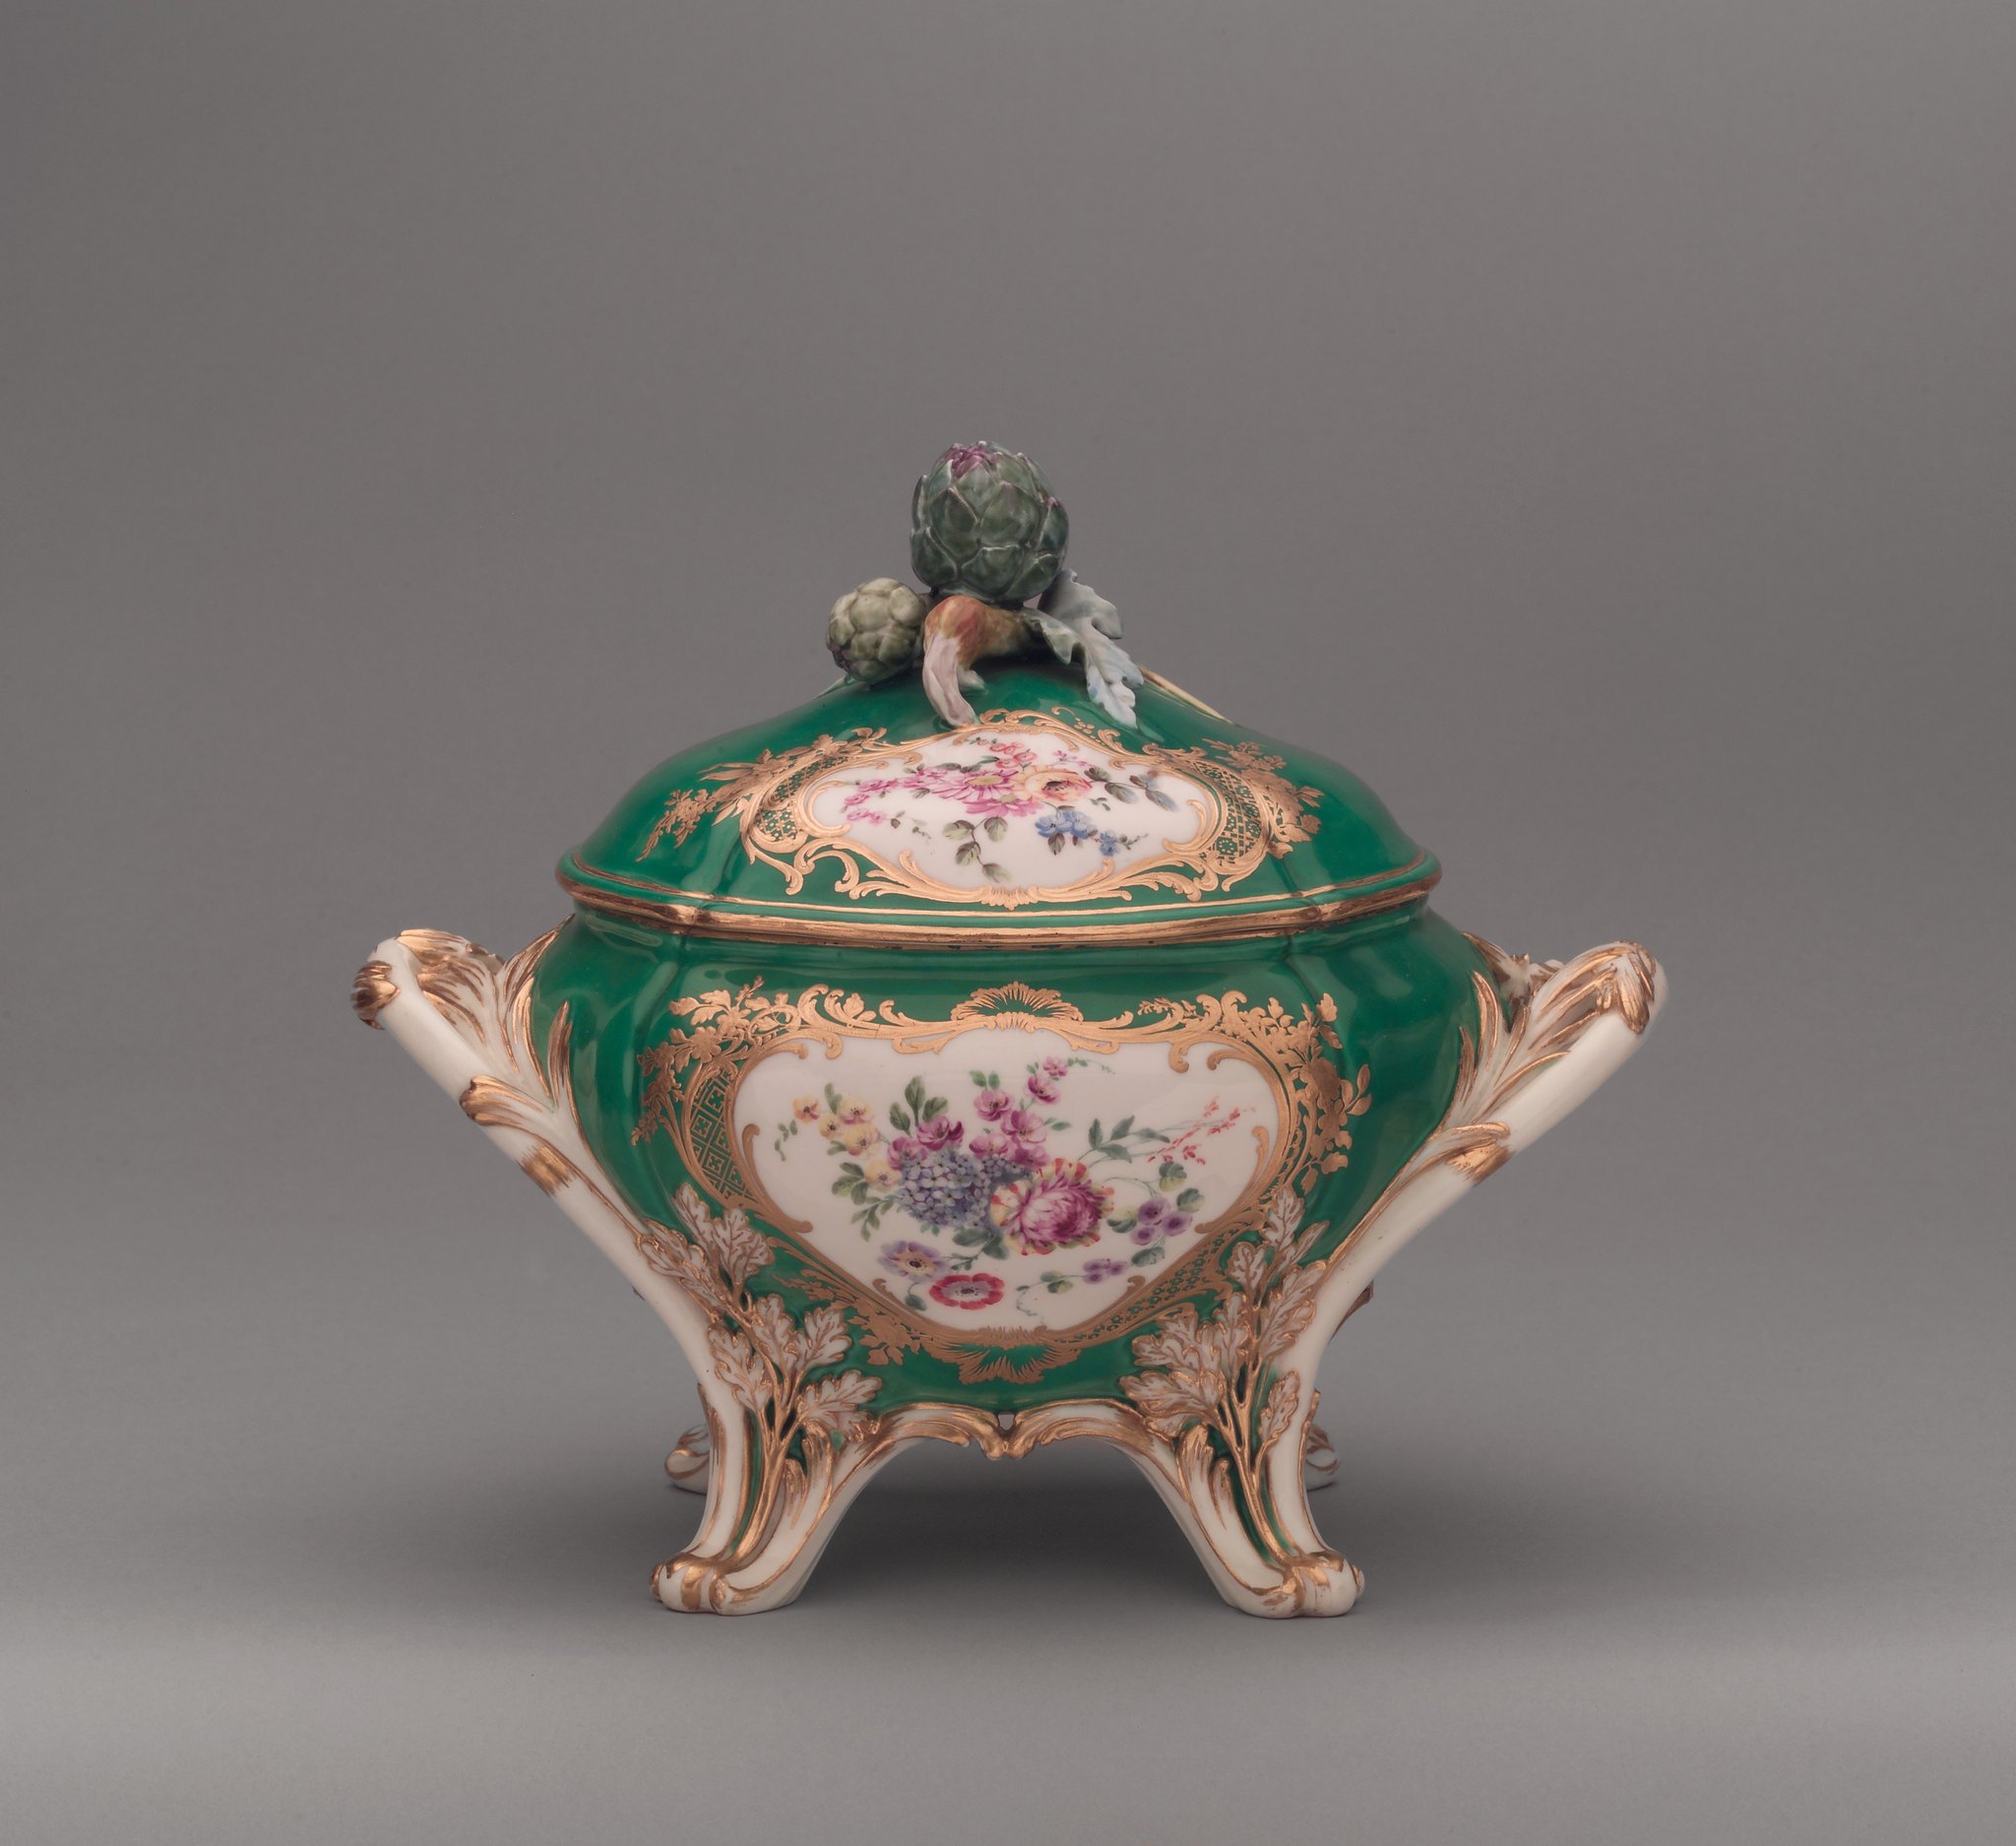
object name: tureen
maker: sèvres manufactory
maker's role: manufactory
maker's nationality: french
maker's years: 1740-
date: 1758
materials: soft paste porcelain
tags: vegetables,flowers